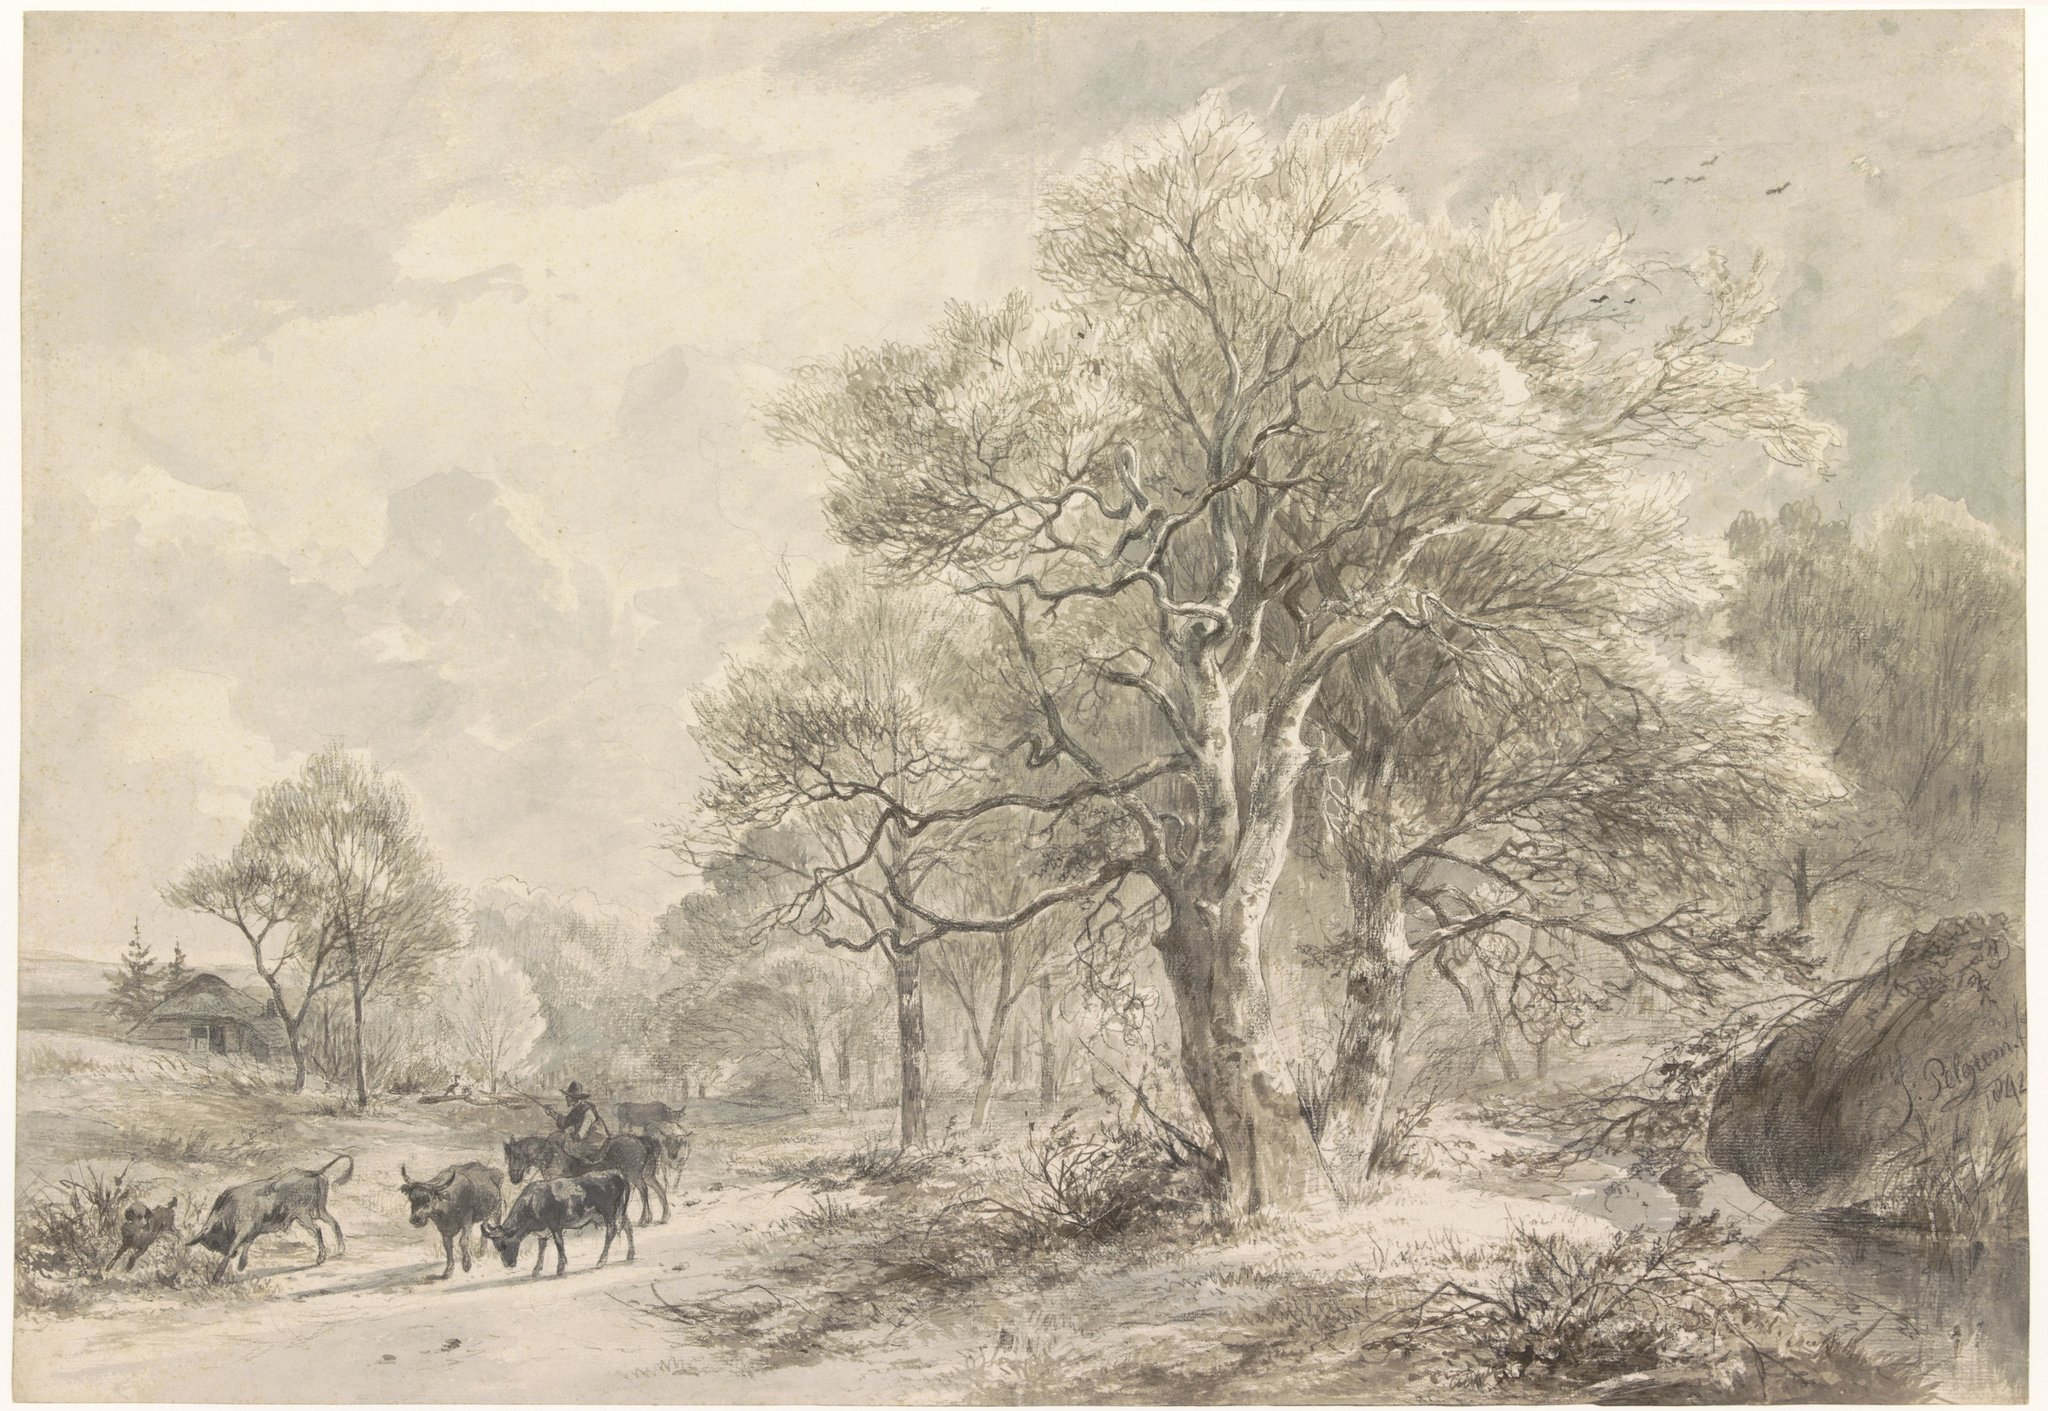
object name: drawing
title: Winterlandschap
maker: jacobus pelgrom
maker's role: draughtsman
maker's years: 1811-1861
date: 1842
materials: chalk, paper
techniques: brush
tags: landscapes in the temperate zone